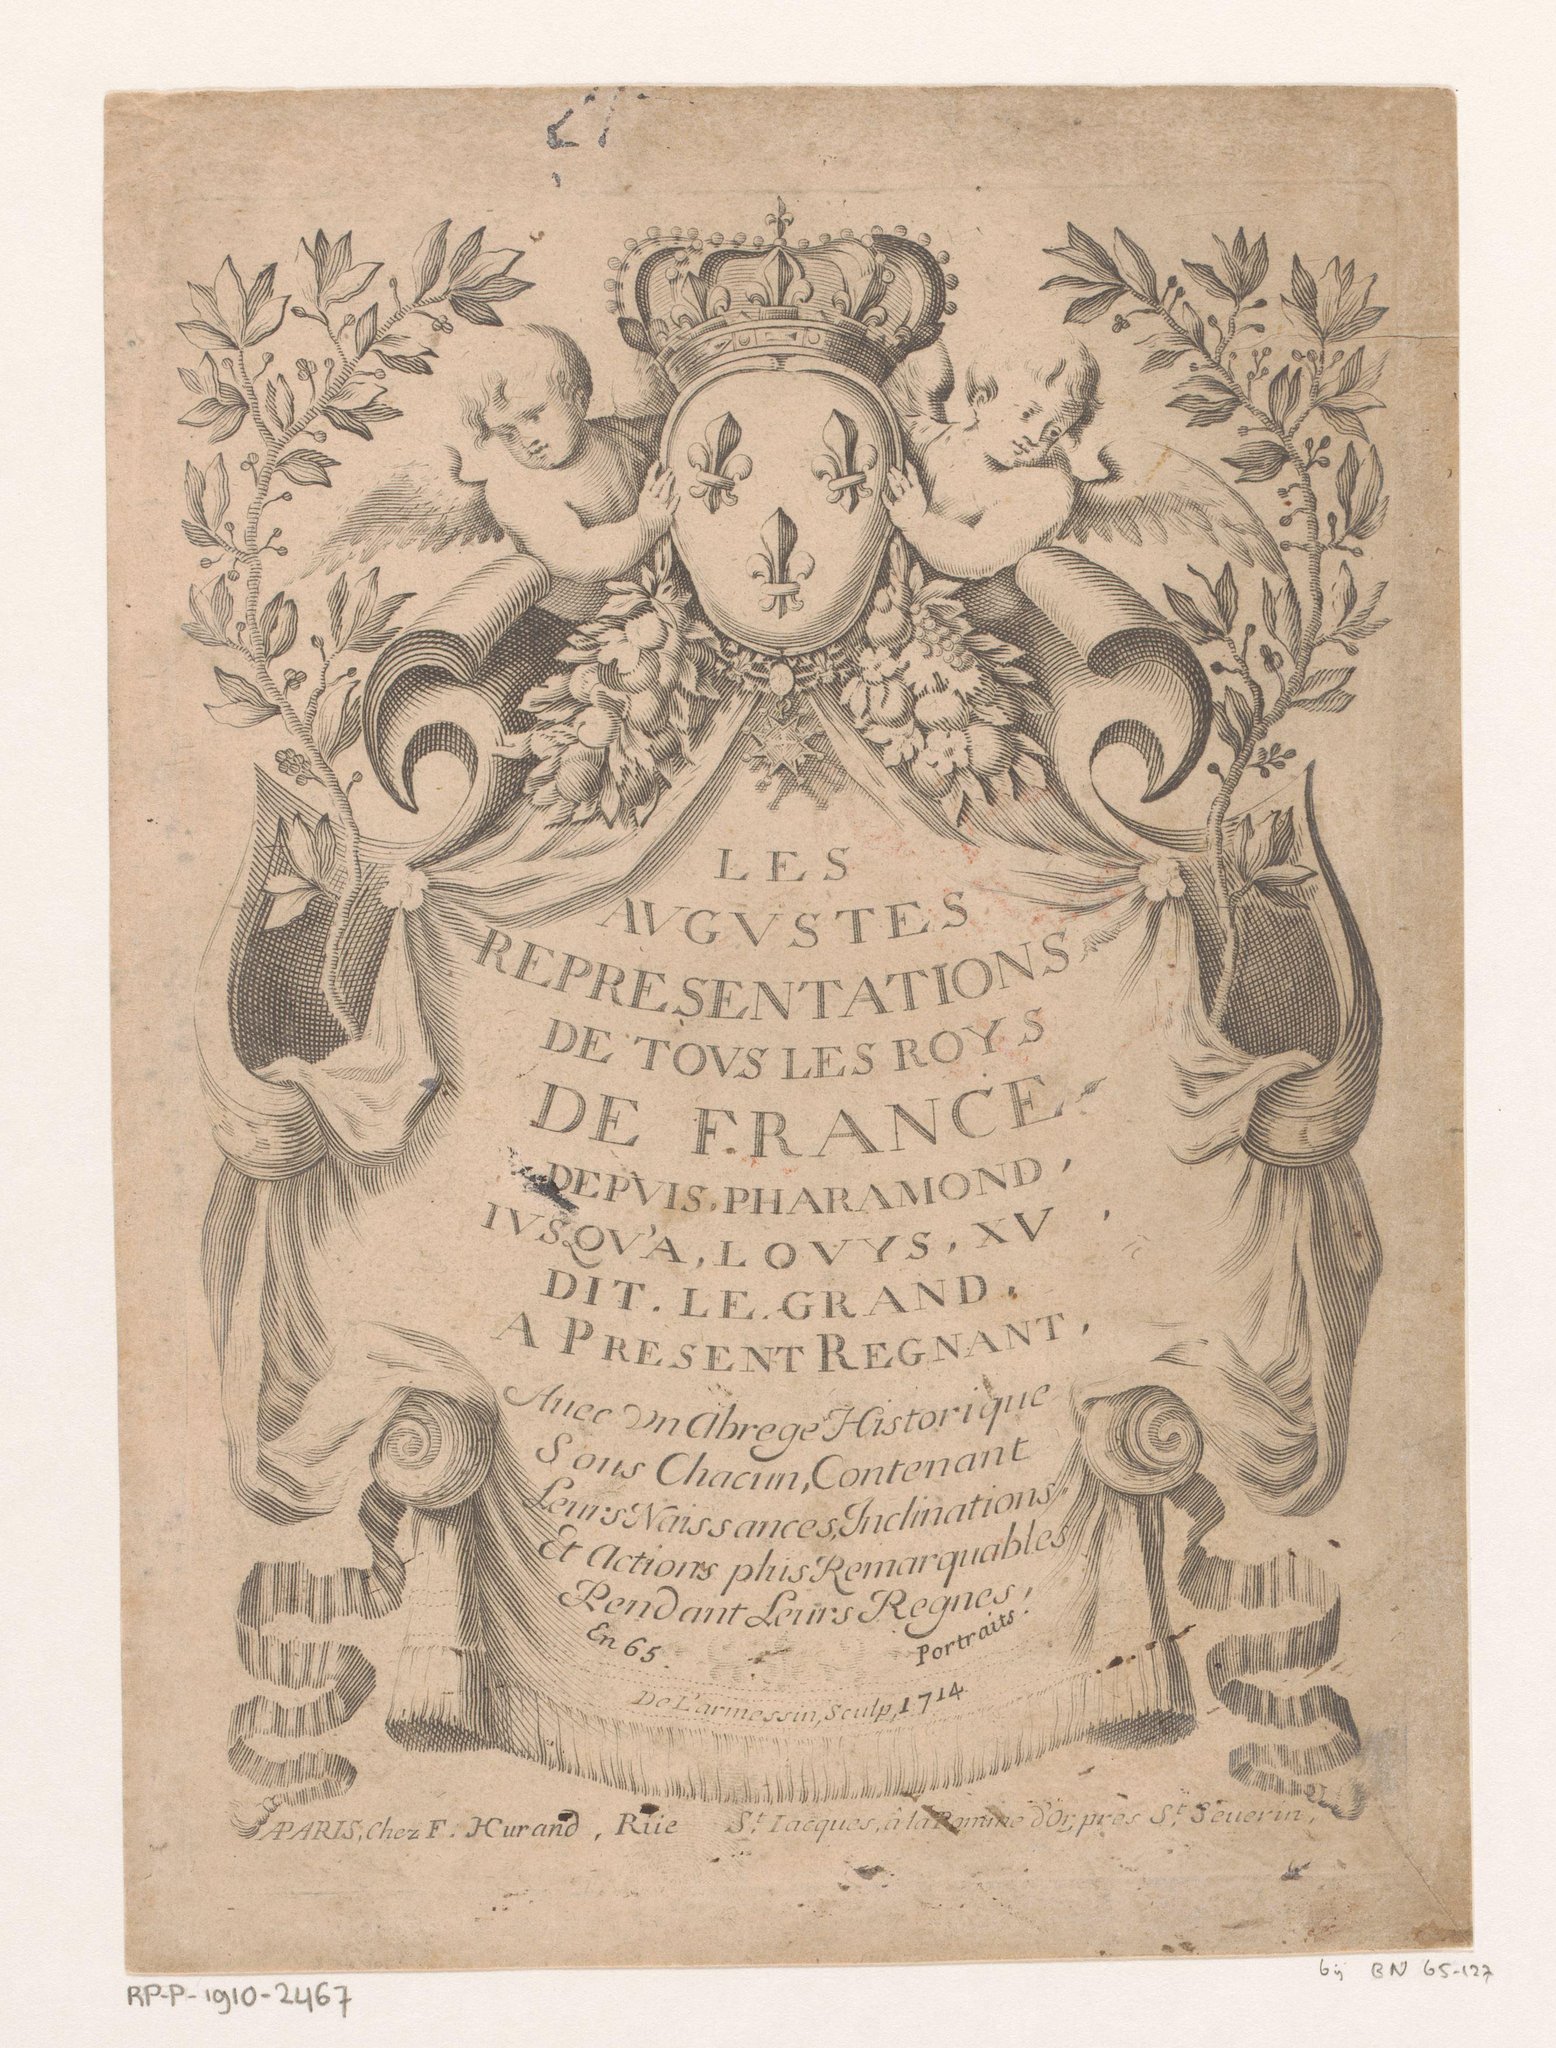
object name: titelprent, frontispice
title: Titelprent met draperie en wapenschild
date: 1714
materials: paper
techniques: engraving, etching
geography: paris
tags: king, armorial bearing, heraldry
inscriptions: collector's mark: Lugt 2228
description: Maakt deel uit van een grootschalige serie met portretten van prominente figuren. Binnen de serie bevindt zich een sectie getiteld 'Les Augustes Représentations De tous les Roys De France depuis Pharamond Iusqu'à Louys XIIII'. De serie werd respectievelijk uitgegeven door Pierre Bertrand, door zijn weduwe en door De Larmessin zelf.